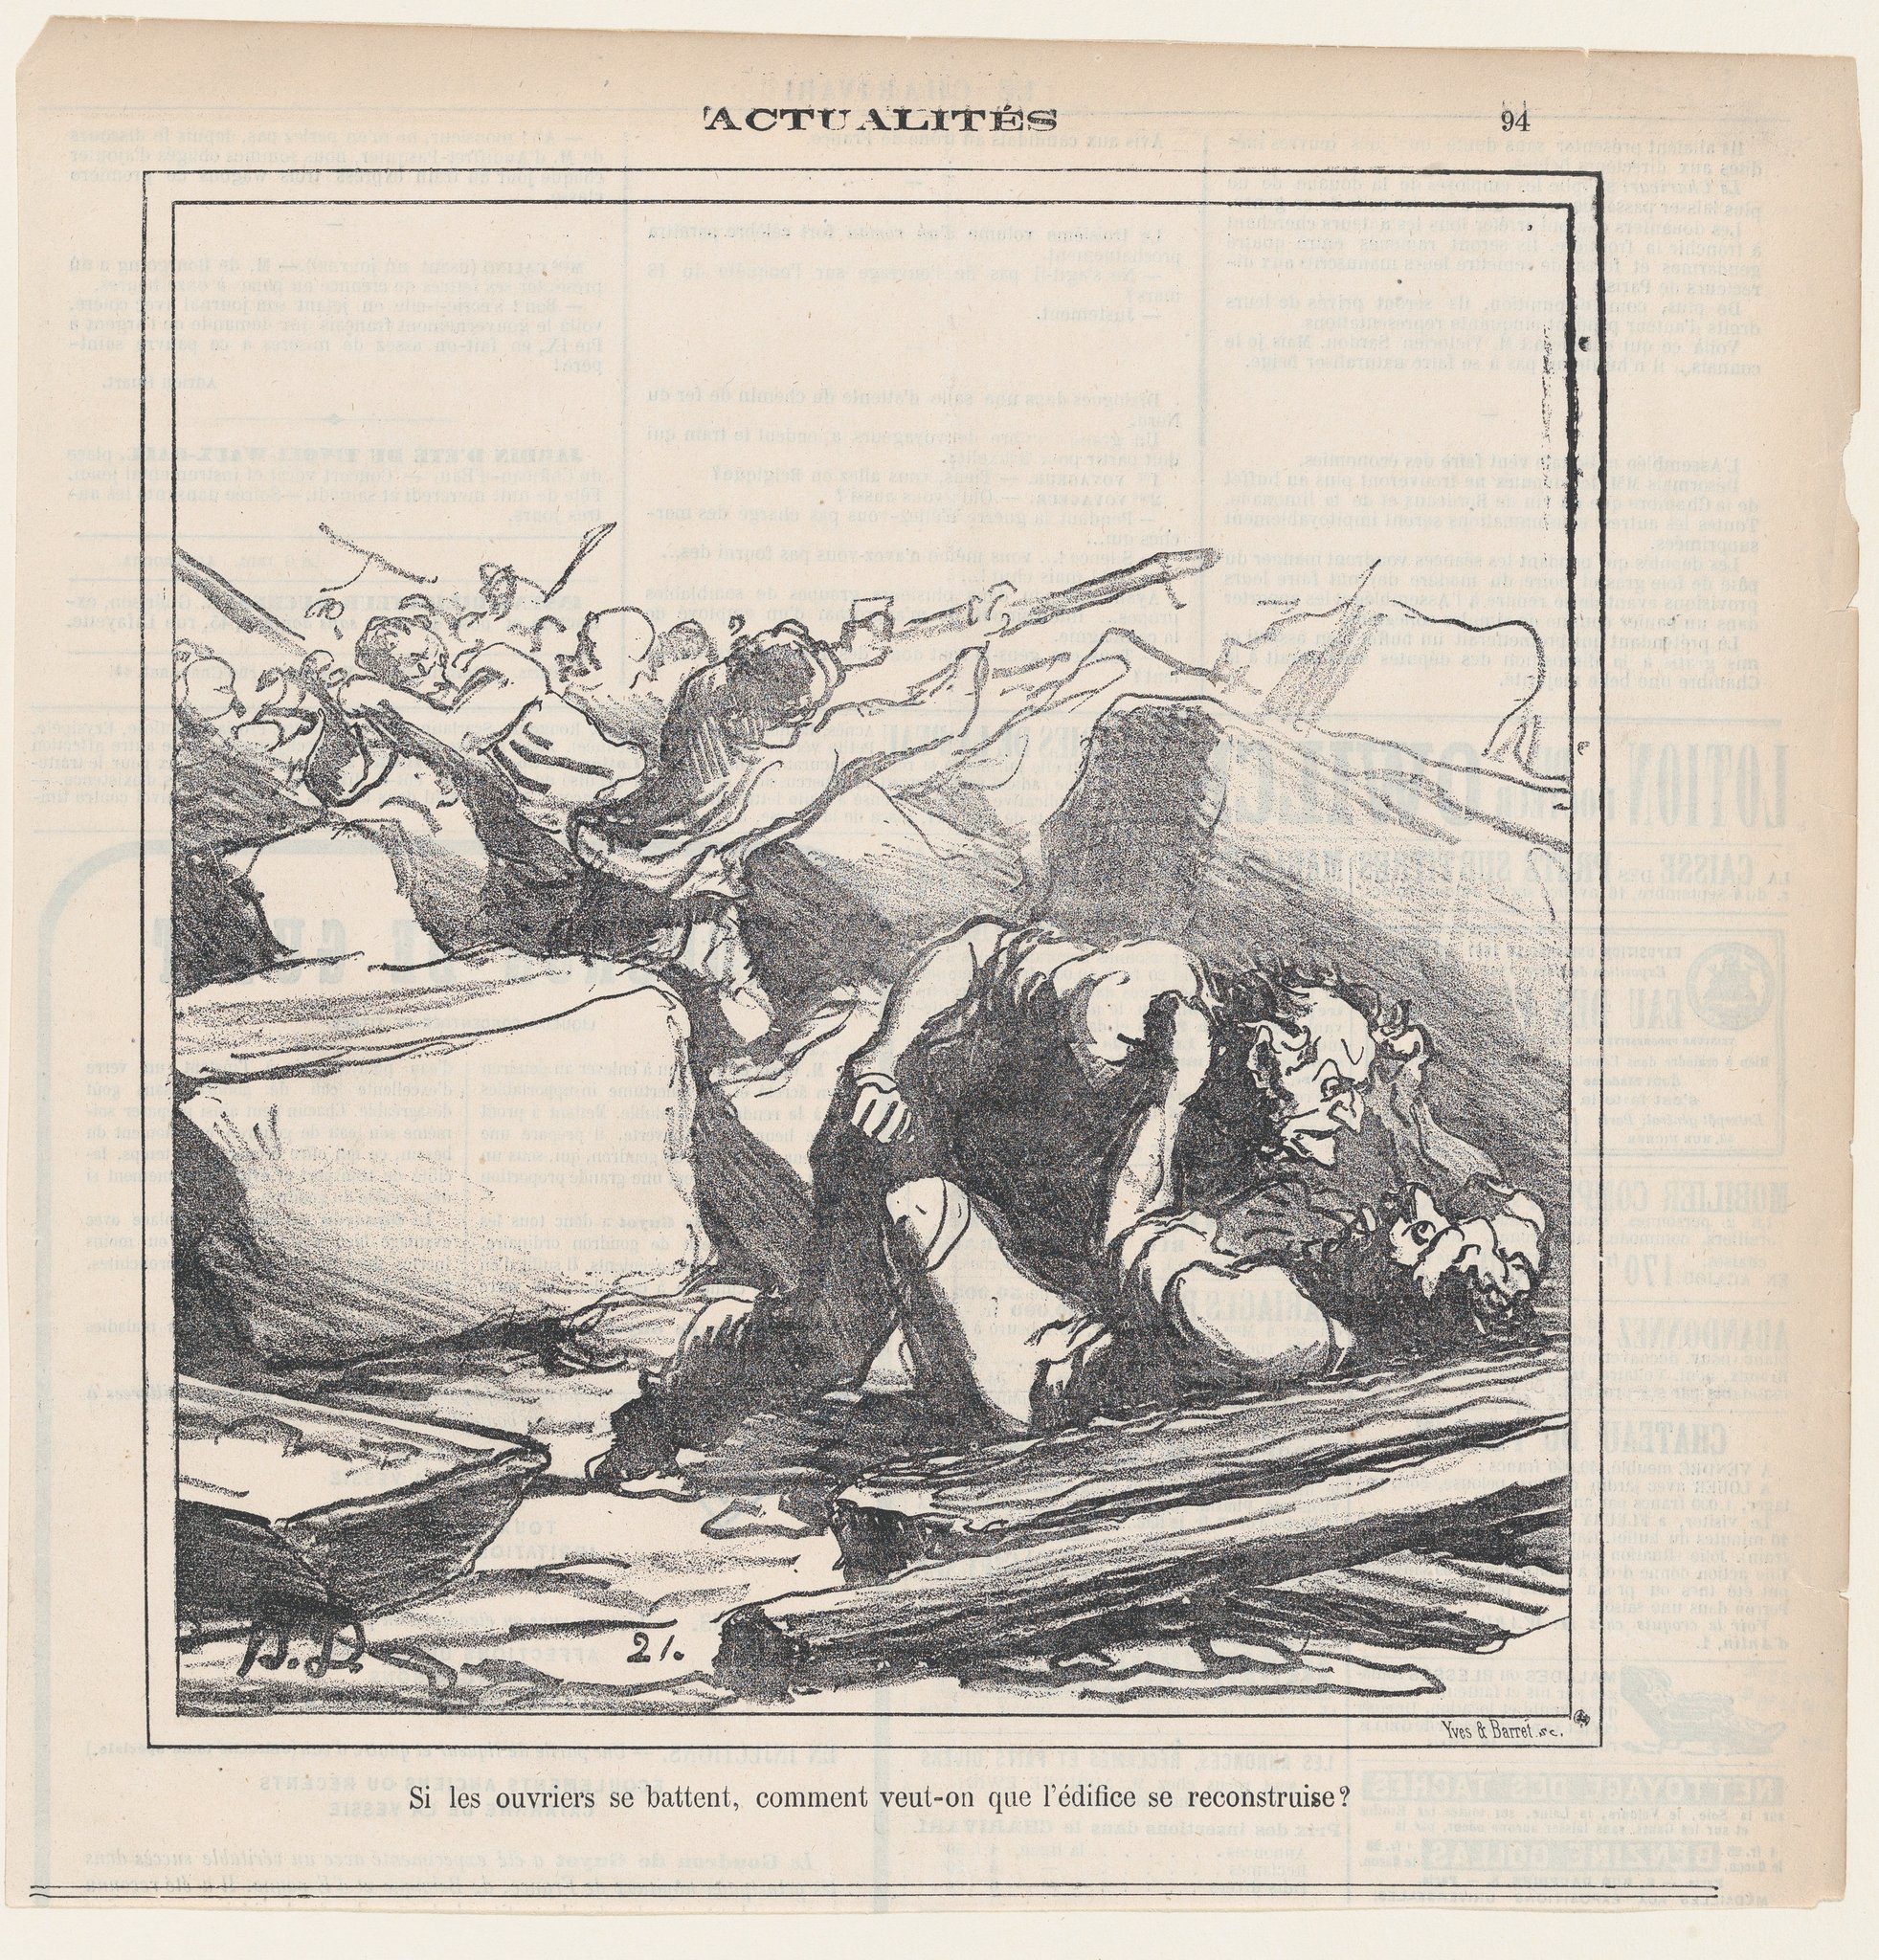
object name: print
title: How can the building be restored, if the workers are fighting between each other!, from 'News of the day,' published in "Le Charivari"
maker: honoré daumier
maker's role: artist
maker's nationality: french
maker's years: 1808-1879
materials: paper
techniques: lithograph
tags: satire,men